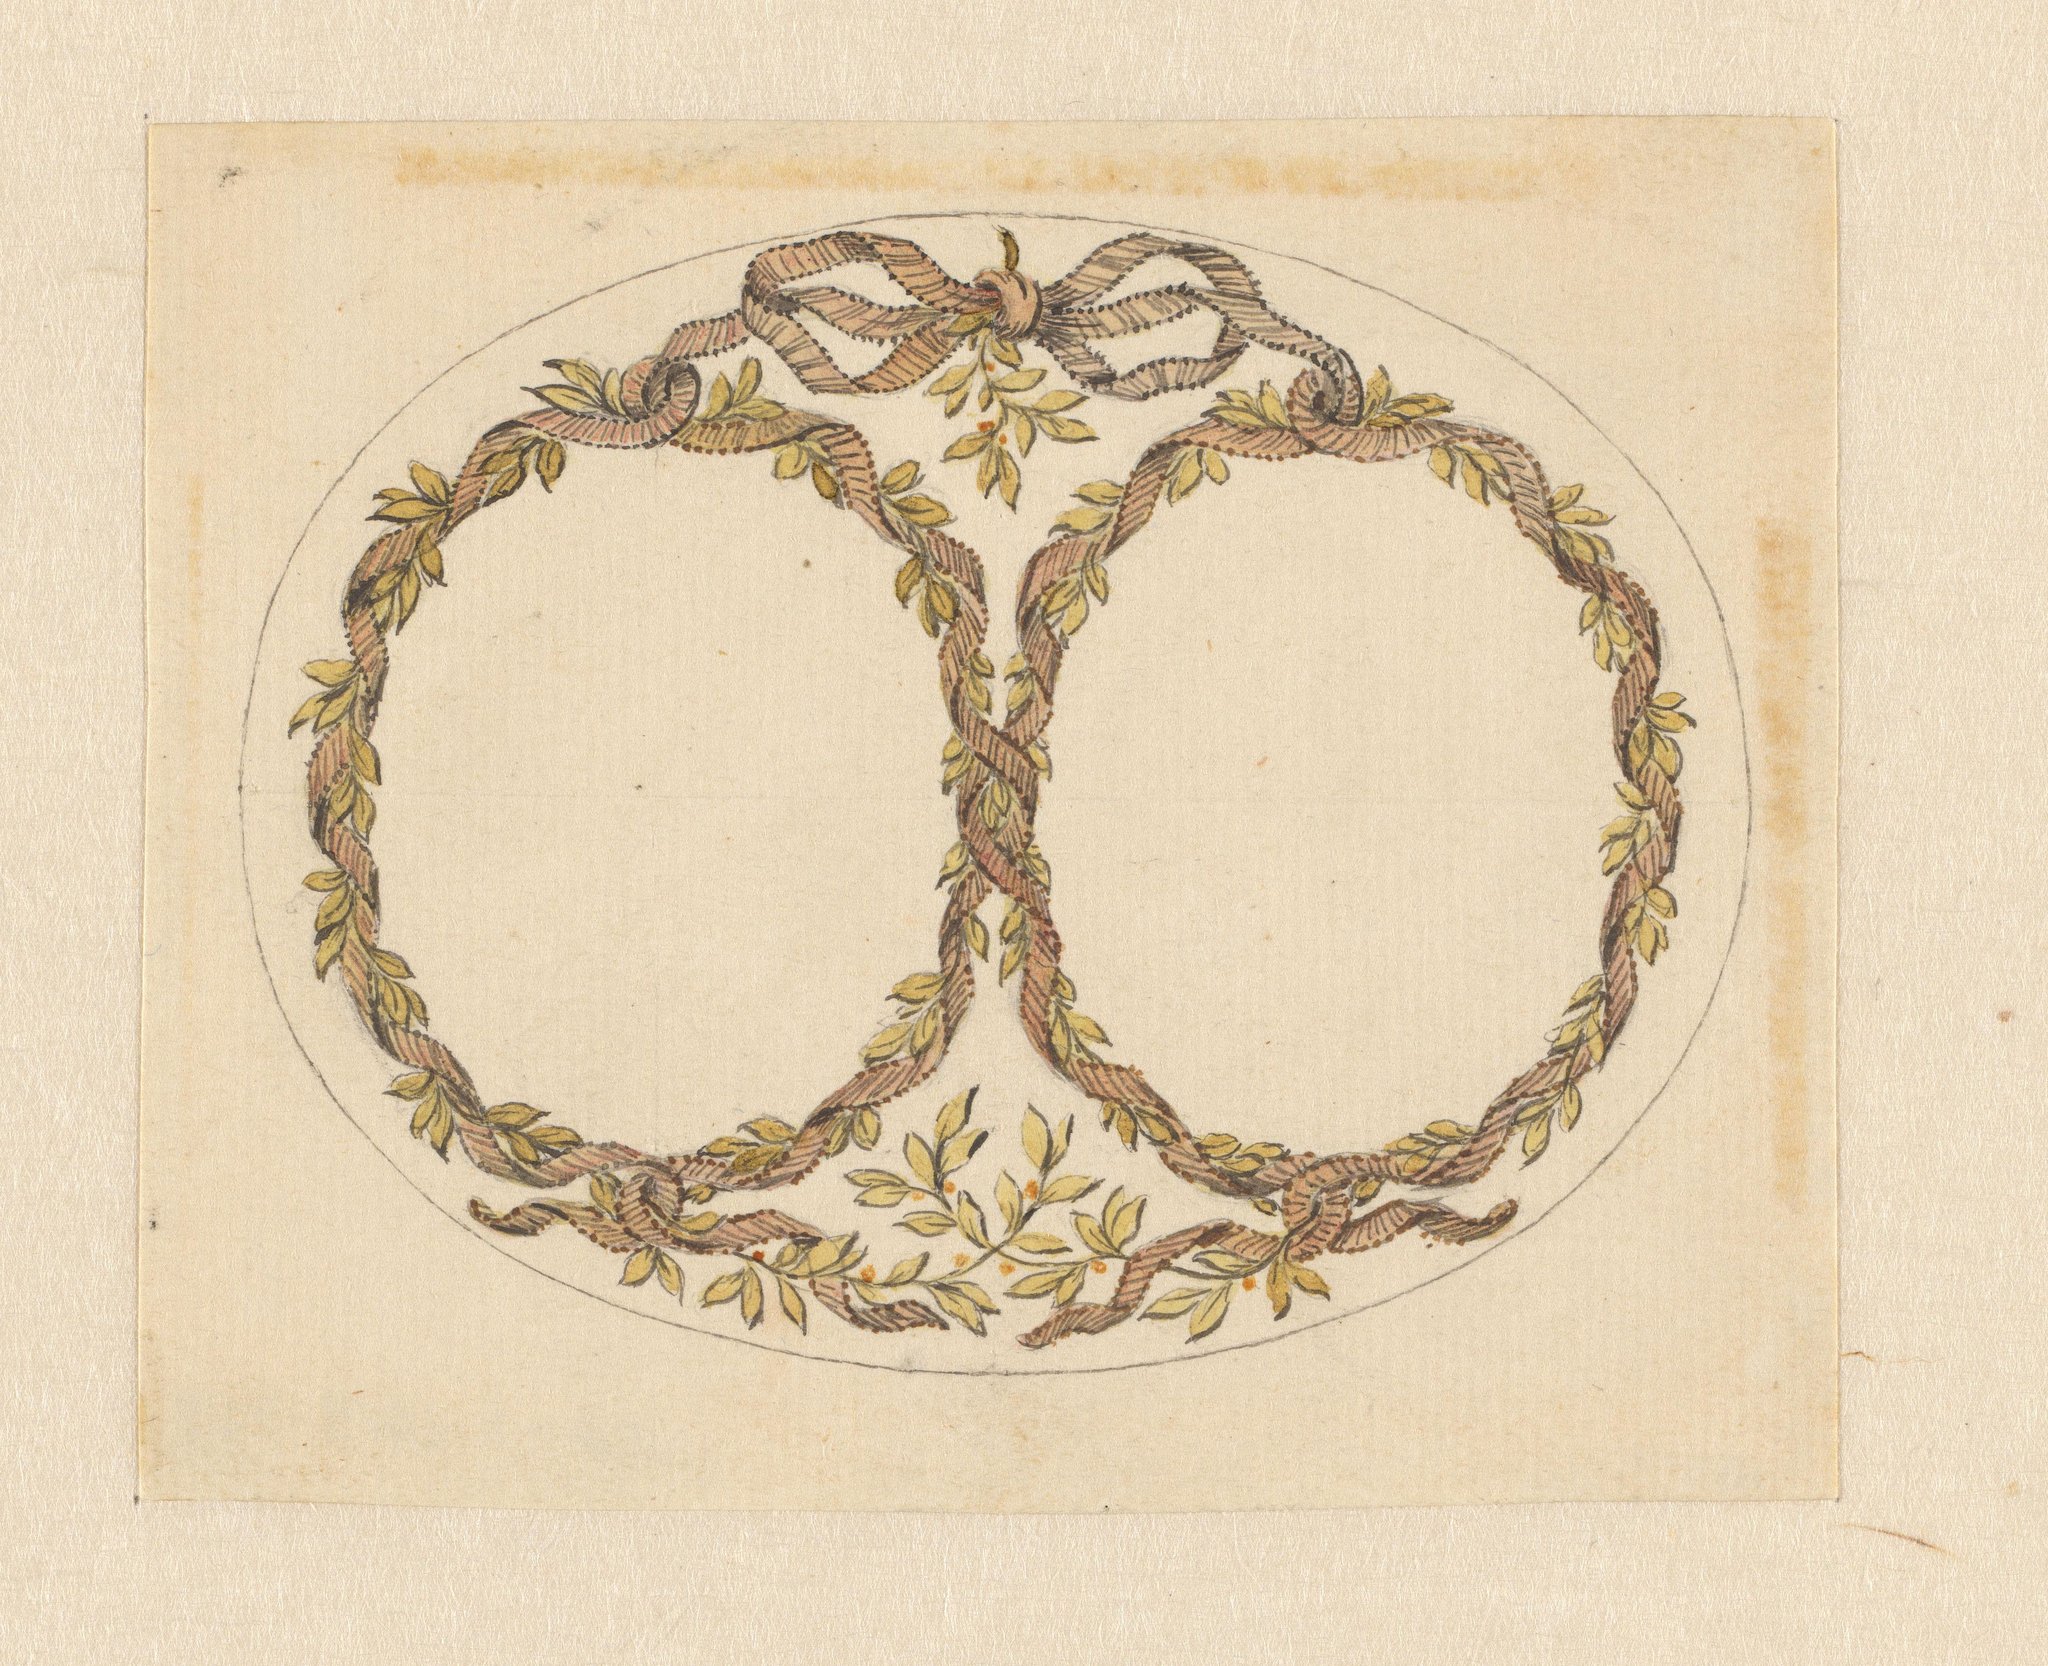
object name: design drawing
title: Snuifdoos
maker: Anonymous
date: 1770-1780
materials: graphite, ink, paper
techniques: brush, pen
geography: paris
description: Ontwerp voor het deksel van een ovale snuifdoos, met twee ovalen binnen met linten omwonden bladertakken.